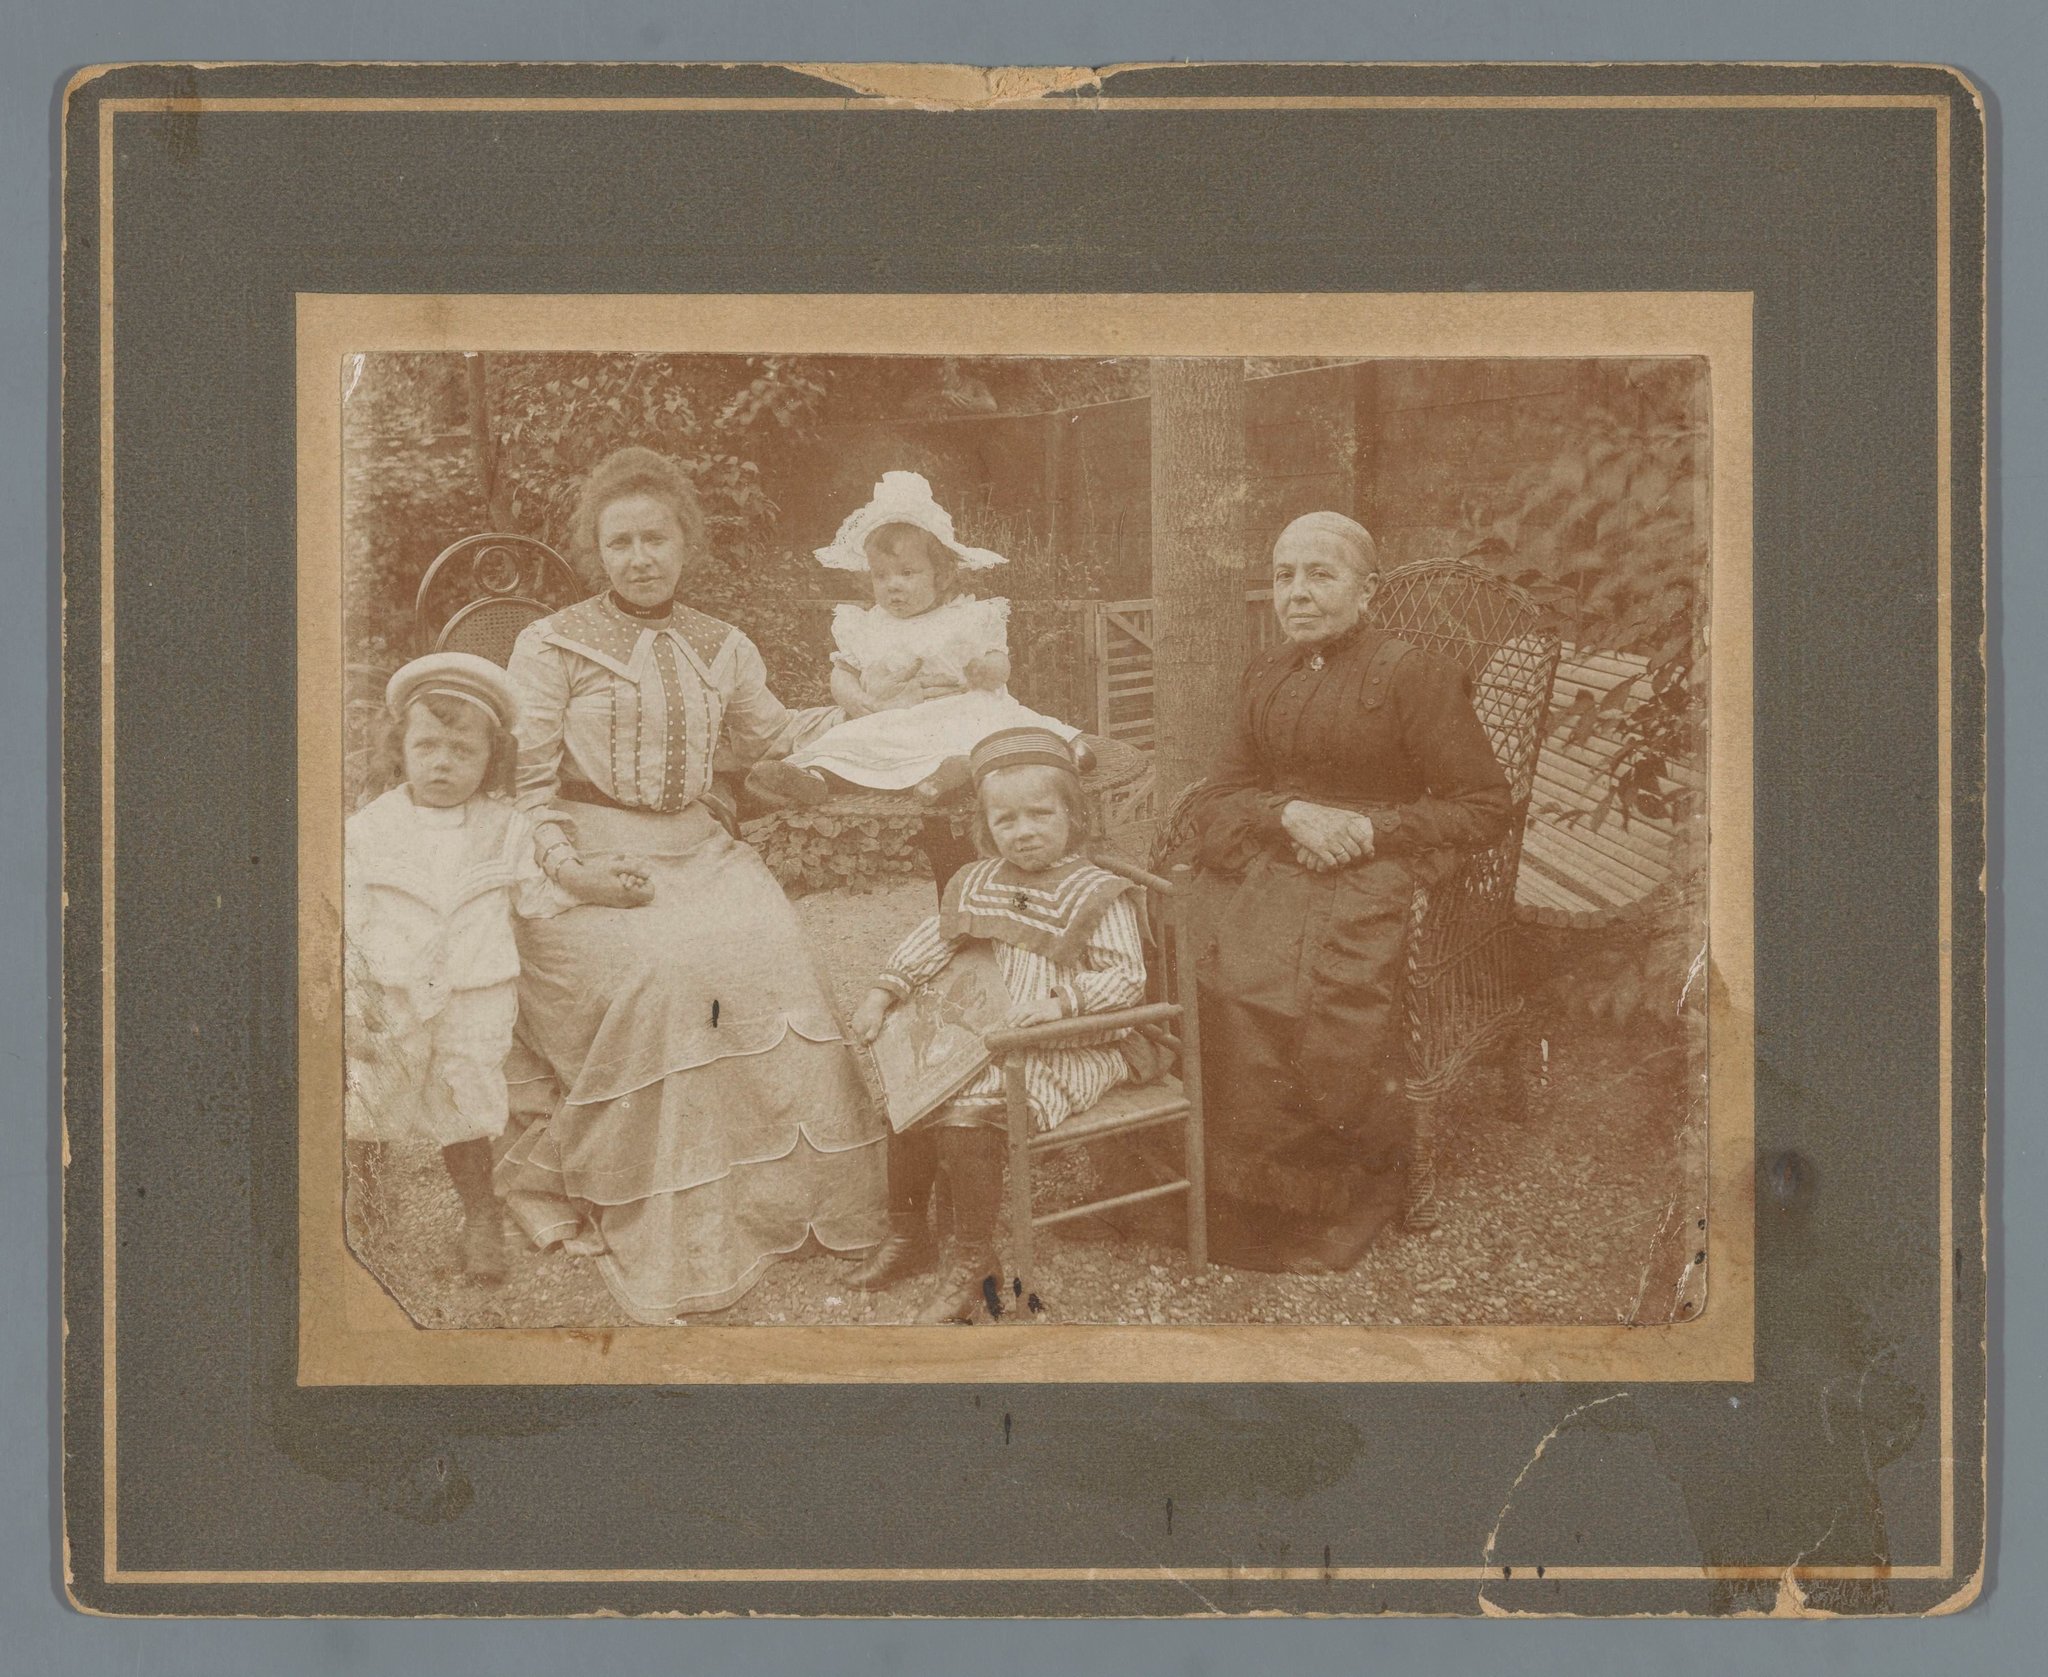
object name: photograph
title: Groepsportret van Wilhelmina Gerarda Hoogendijk met haar drie kinderen en grootmoeder in de tuin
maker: willem carel van der kop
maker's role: amateurfotograaf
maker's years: 1869-1924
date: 1900-1910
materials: photographic support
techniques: collodion silver print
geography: schoonhoven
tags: amsterdam, painter, sculptor, adrianus johannes van der kop (ad), family group, especially parents with their child(ren), garden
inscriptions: inscription: ‘Jan v Gooienstraat 66 Den Haag Eering’